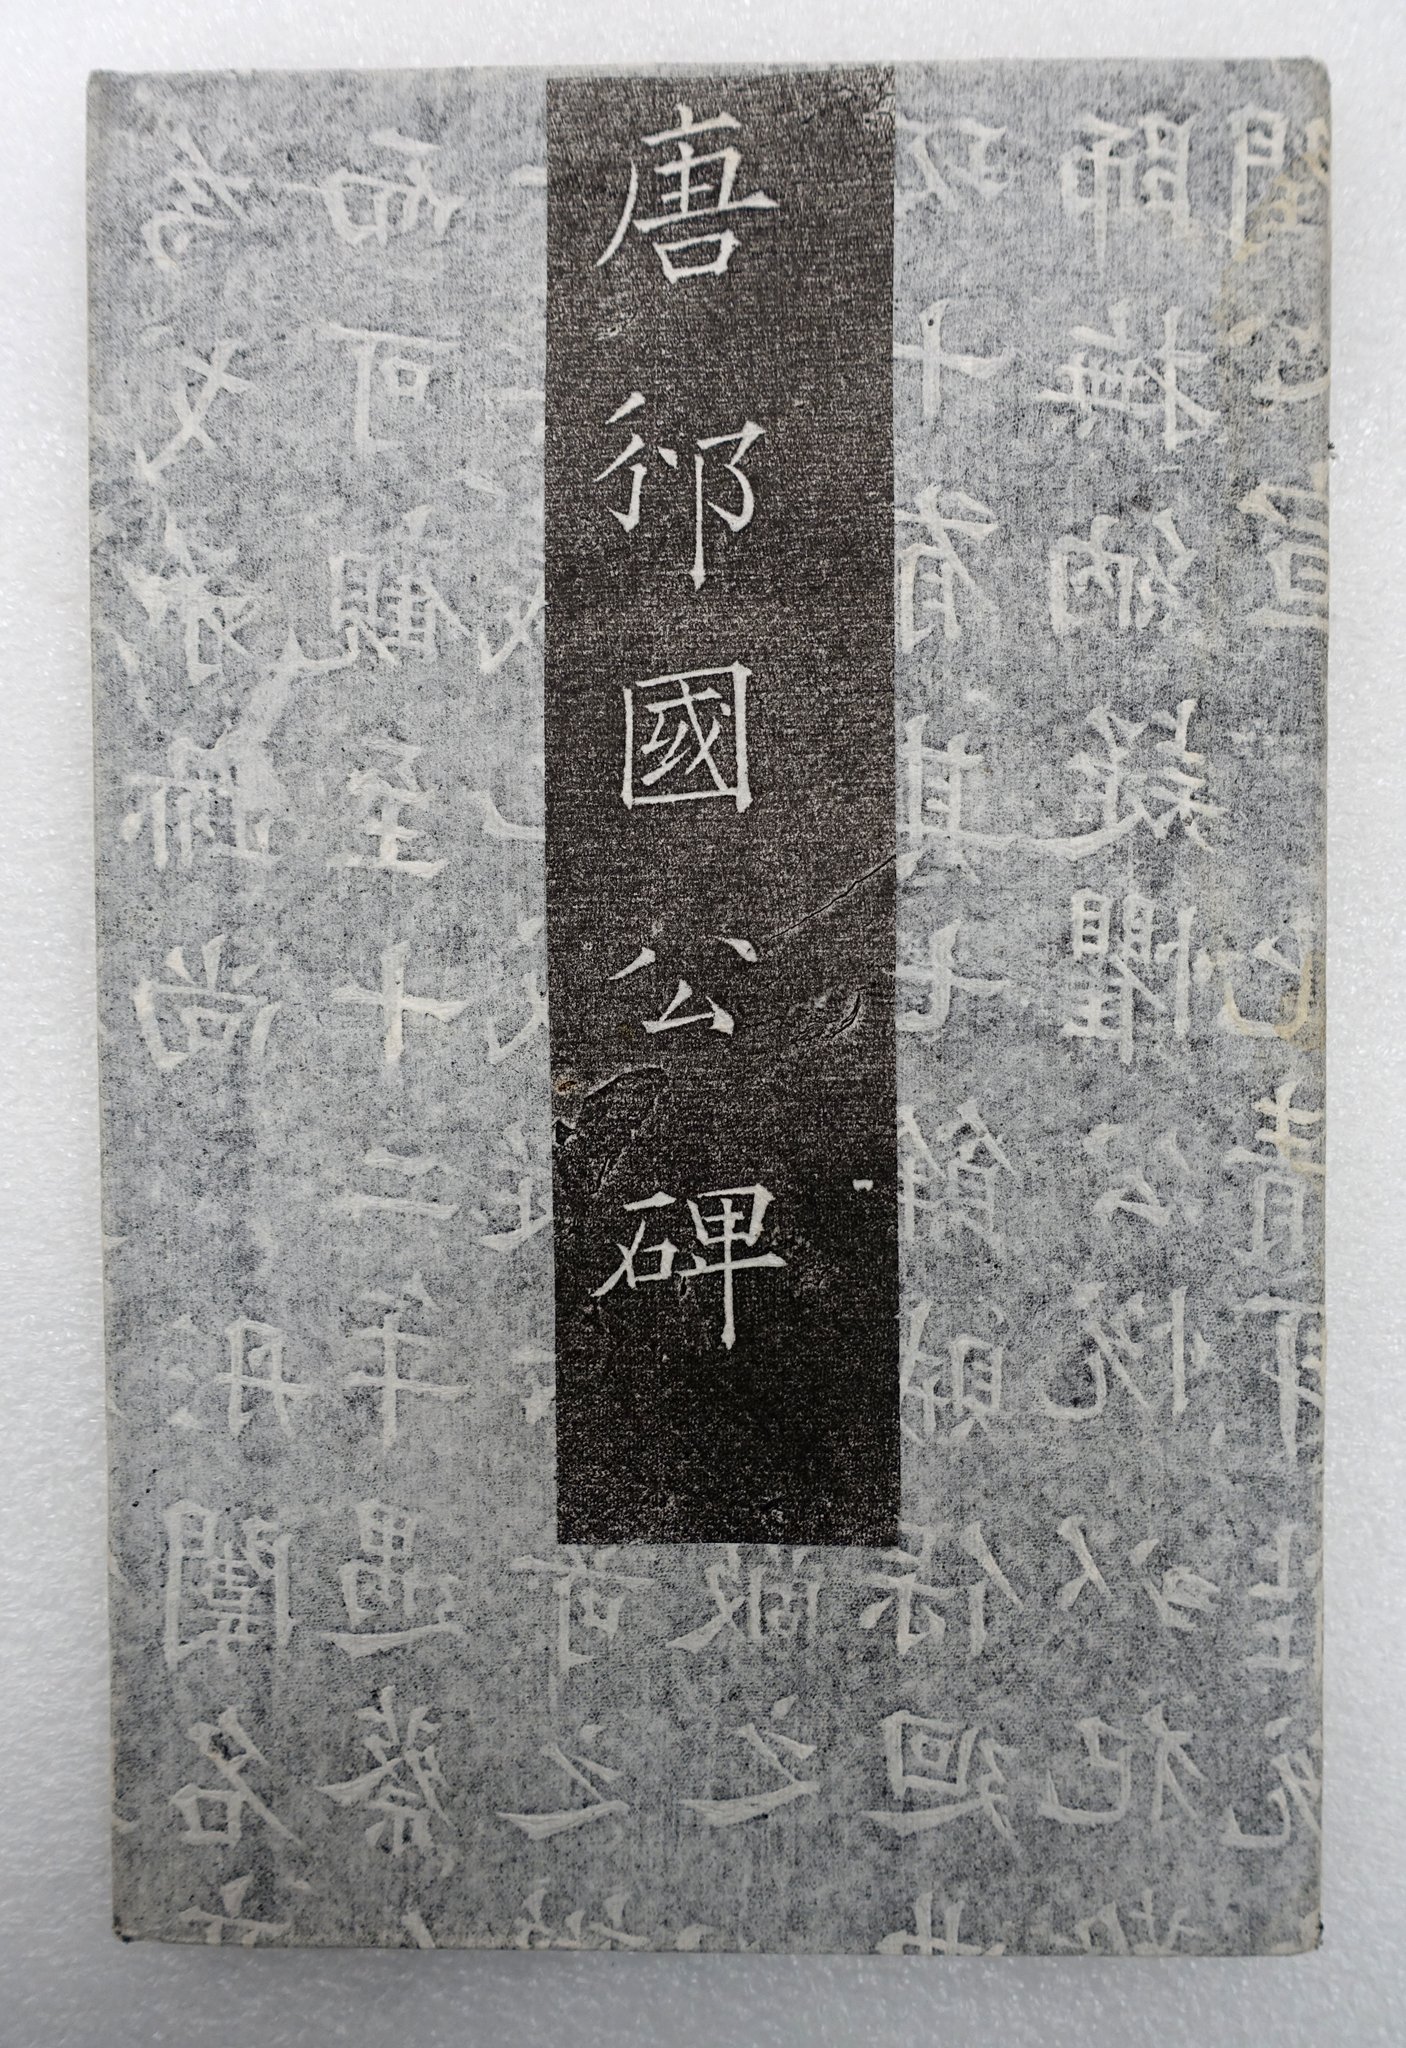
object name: rubbing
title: Epitaph for the Duke of Bin, Liang Shouqian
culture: chinese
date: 1901-2000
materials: ink, paper